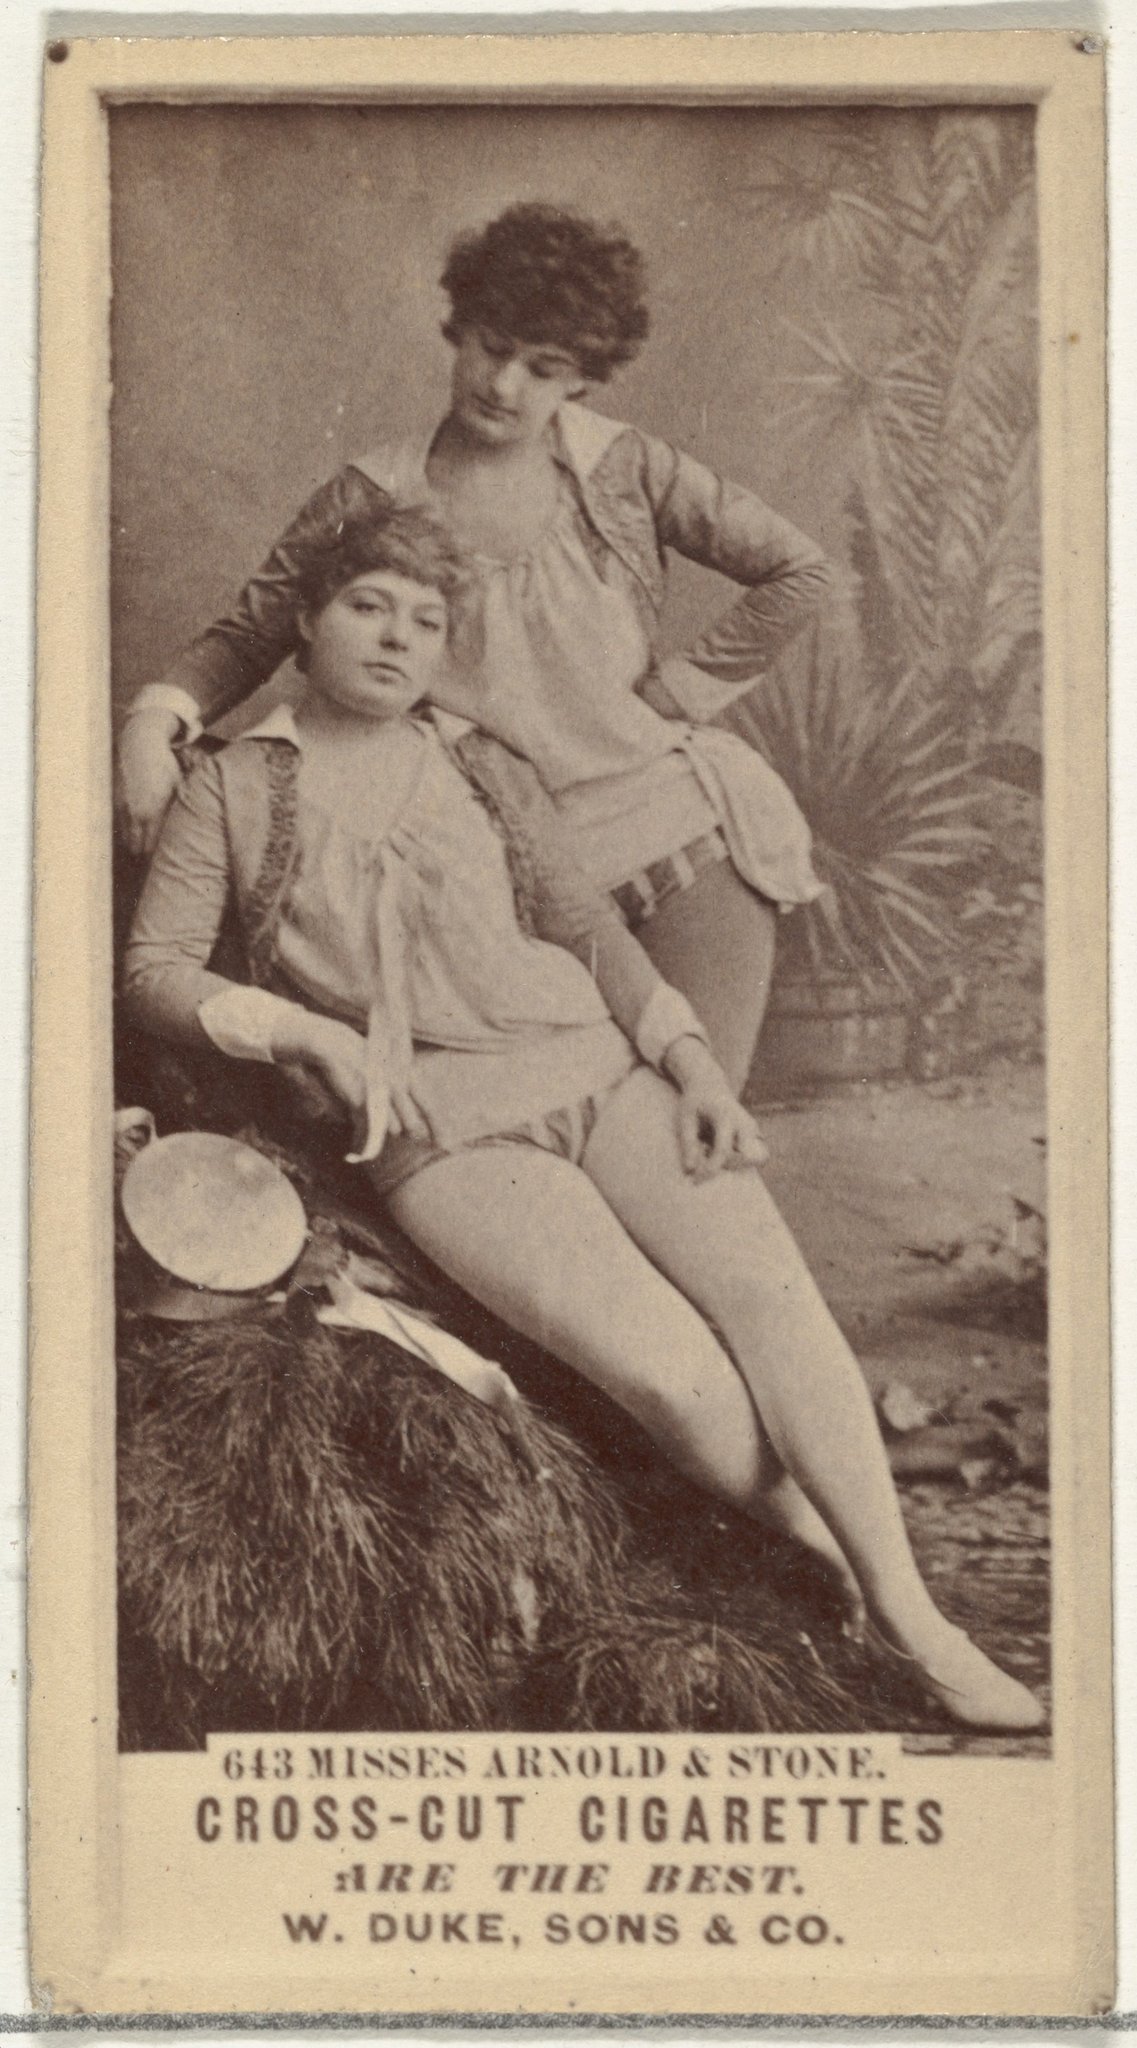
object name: photograph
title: Card Number 613, Misses Arnold and Stone, from the Actors and Actresses series (N145-3) issued by Duke Sons & Co. to promote Cross Cut Cigarettes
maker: w. duke, sons & co.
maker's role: publisher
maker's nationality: american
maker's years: 1870-1920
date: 1880-1889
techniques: albumen silver print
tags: portraits,women,actresses